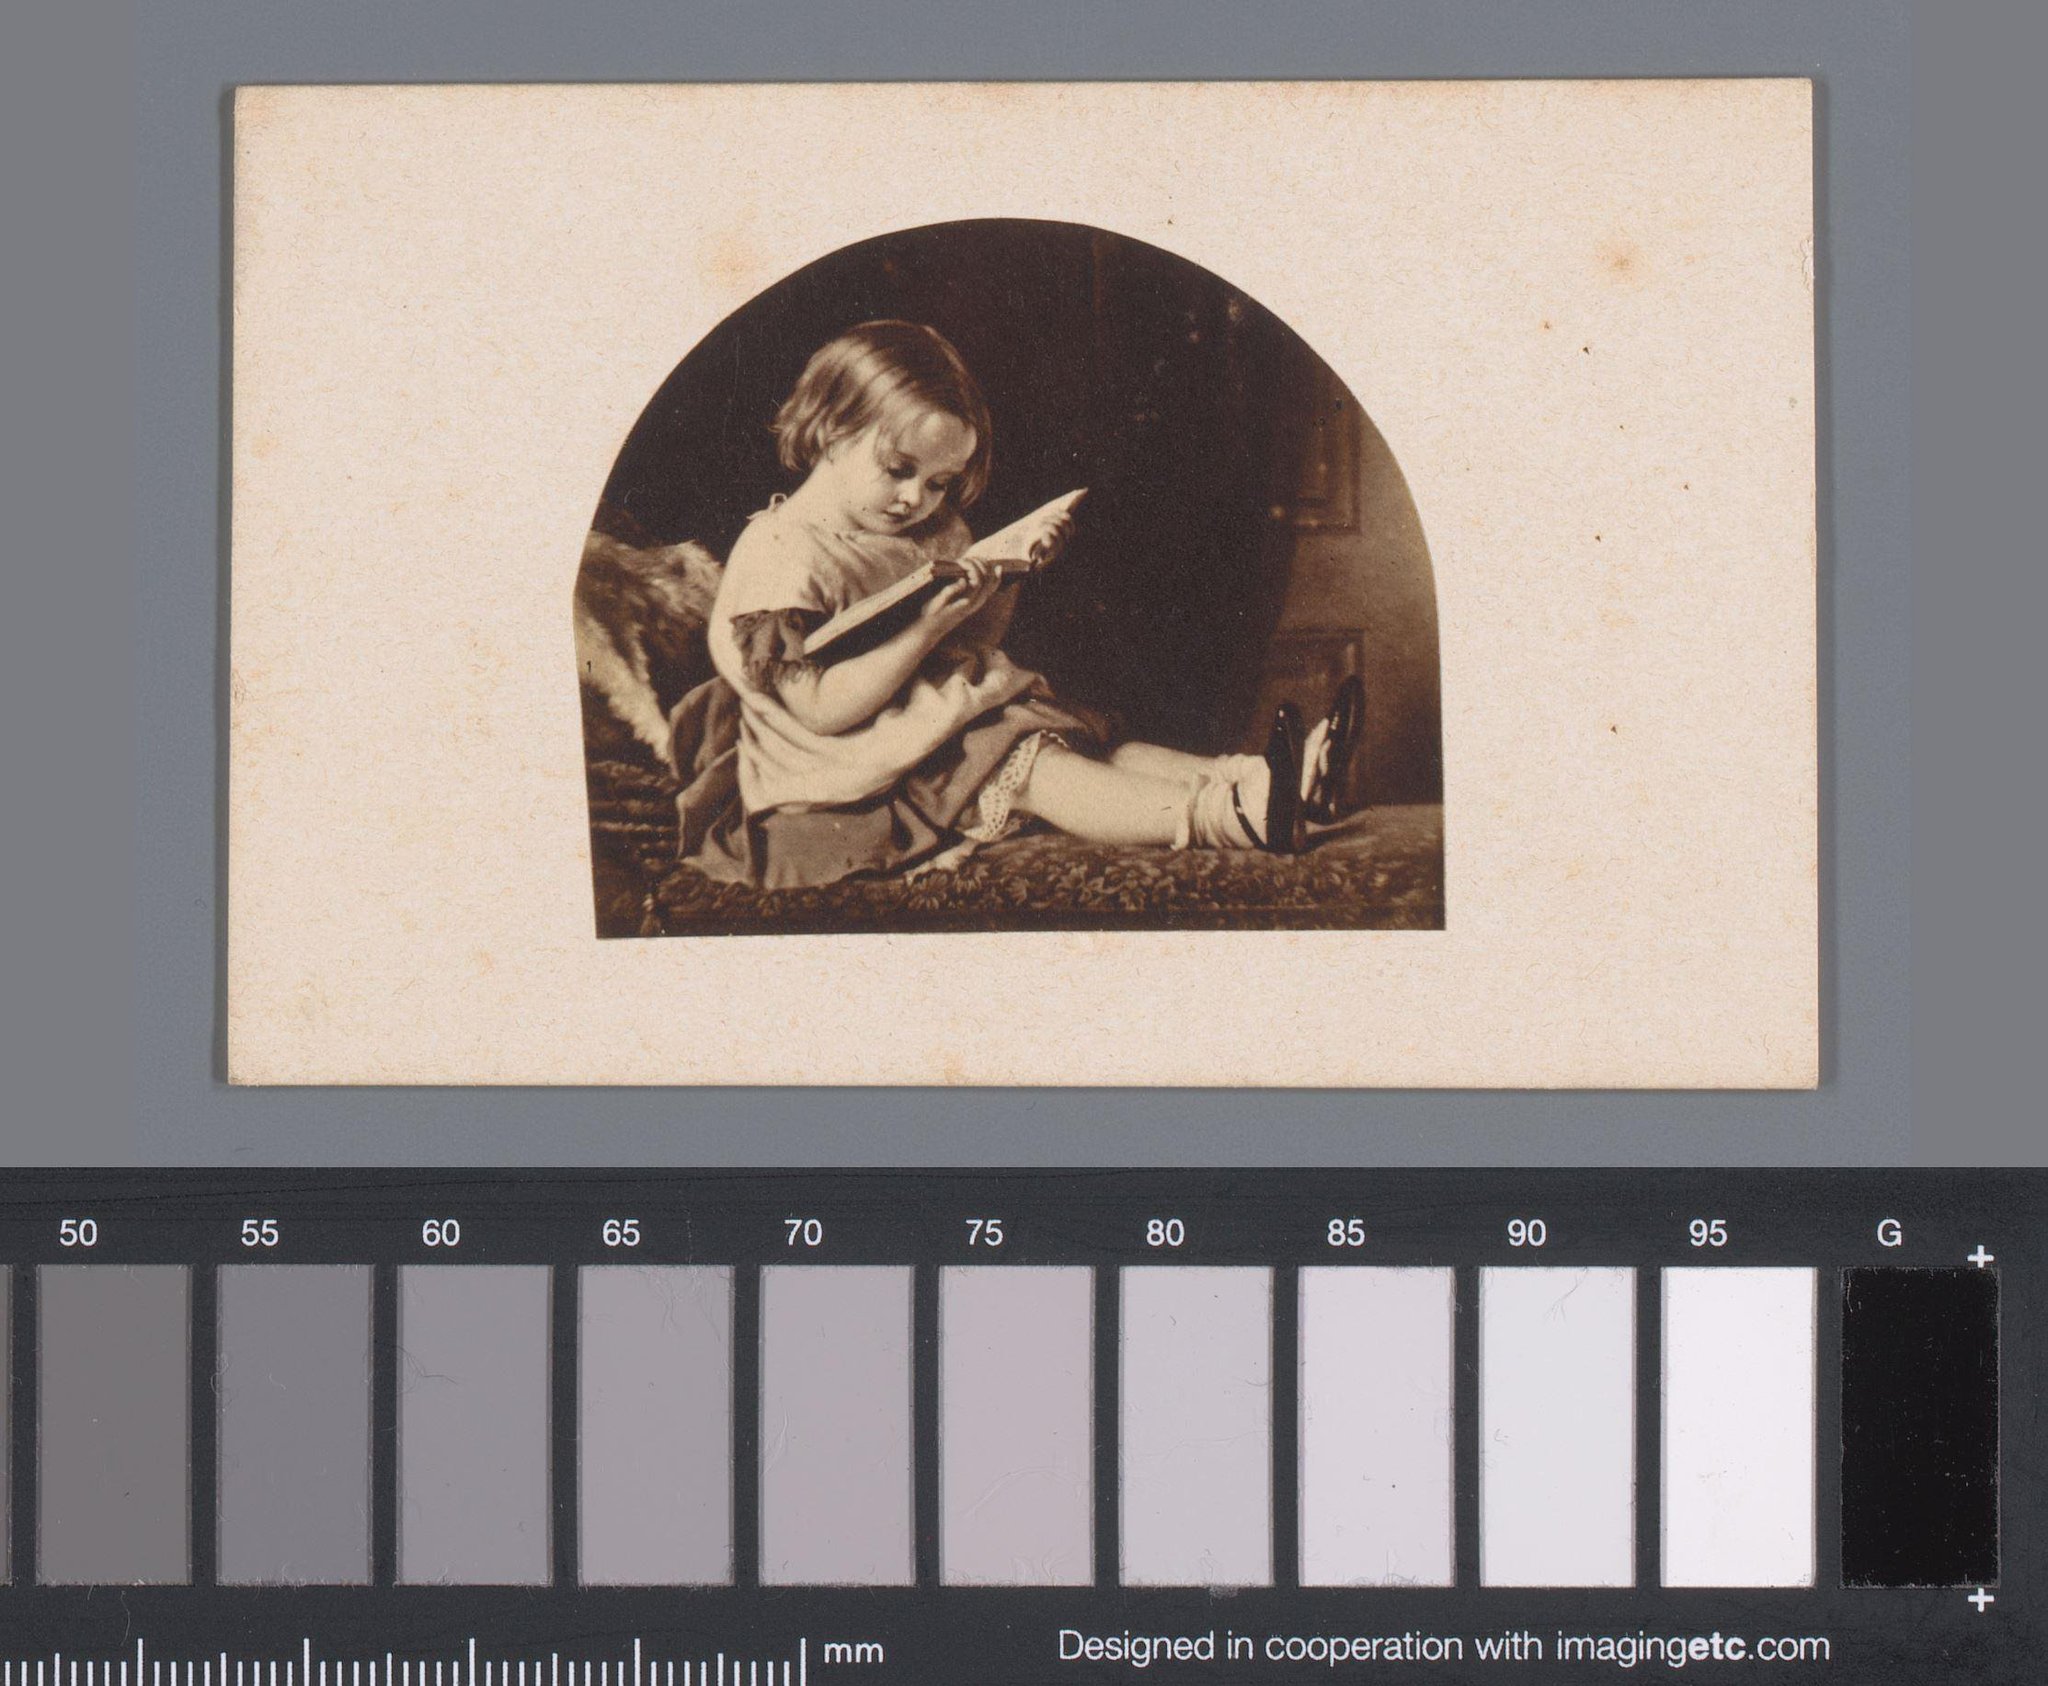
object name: reproduction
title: Fotoreproductie van een schilderij van een lezend meisje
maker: Anonymous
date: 1855-1885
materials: cardboard, paper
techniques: albumen print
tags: reading, girl (child between toddler and youth)